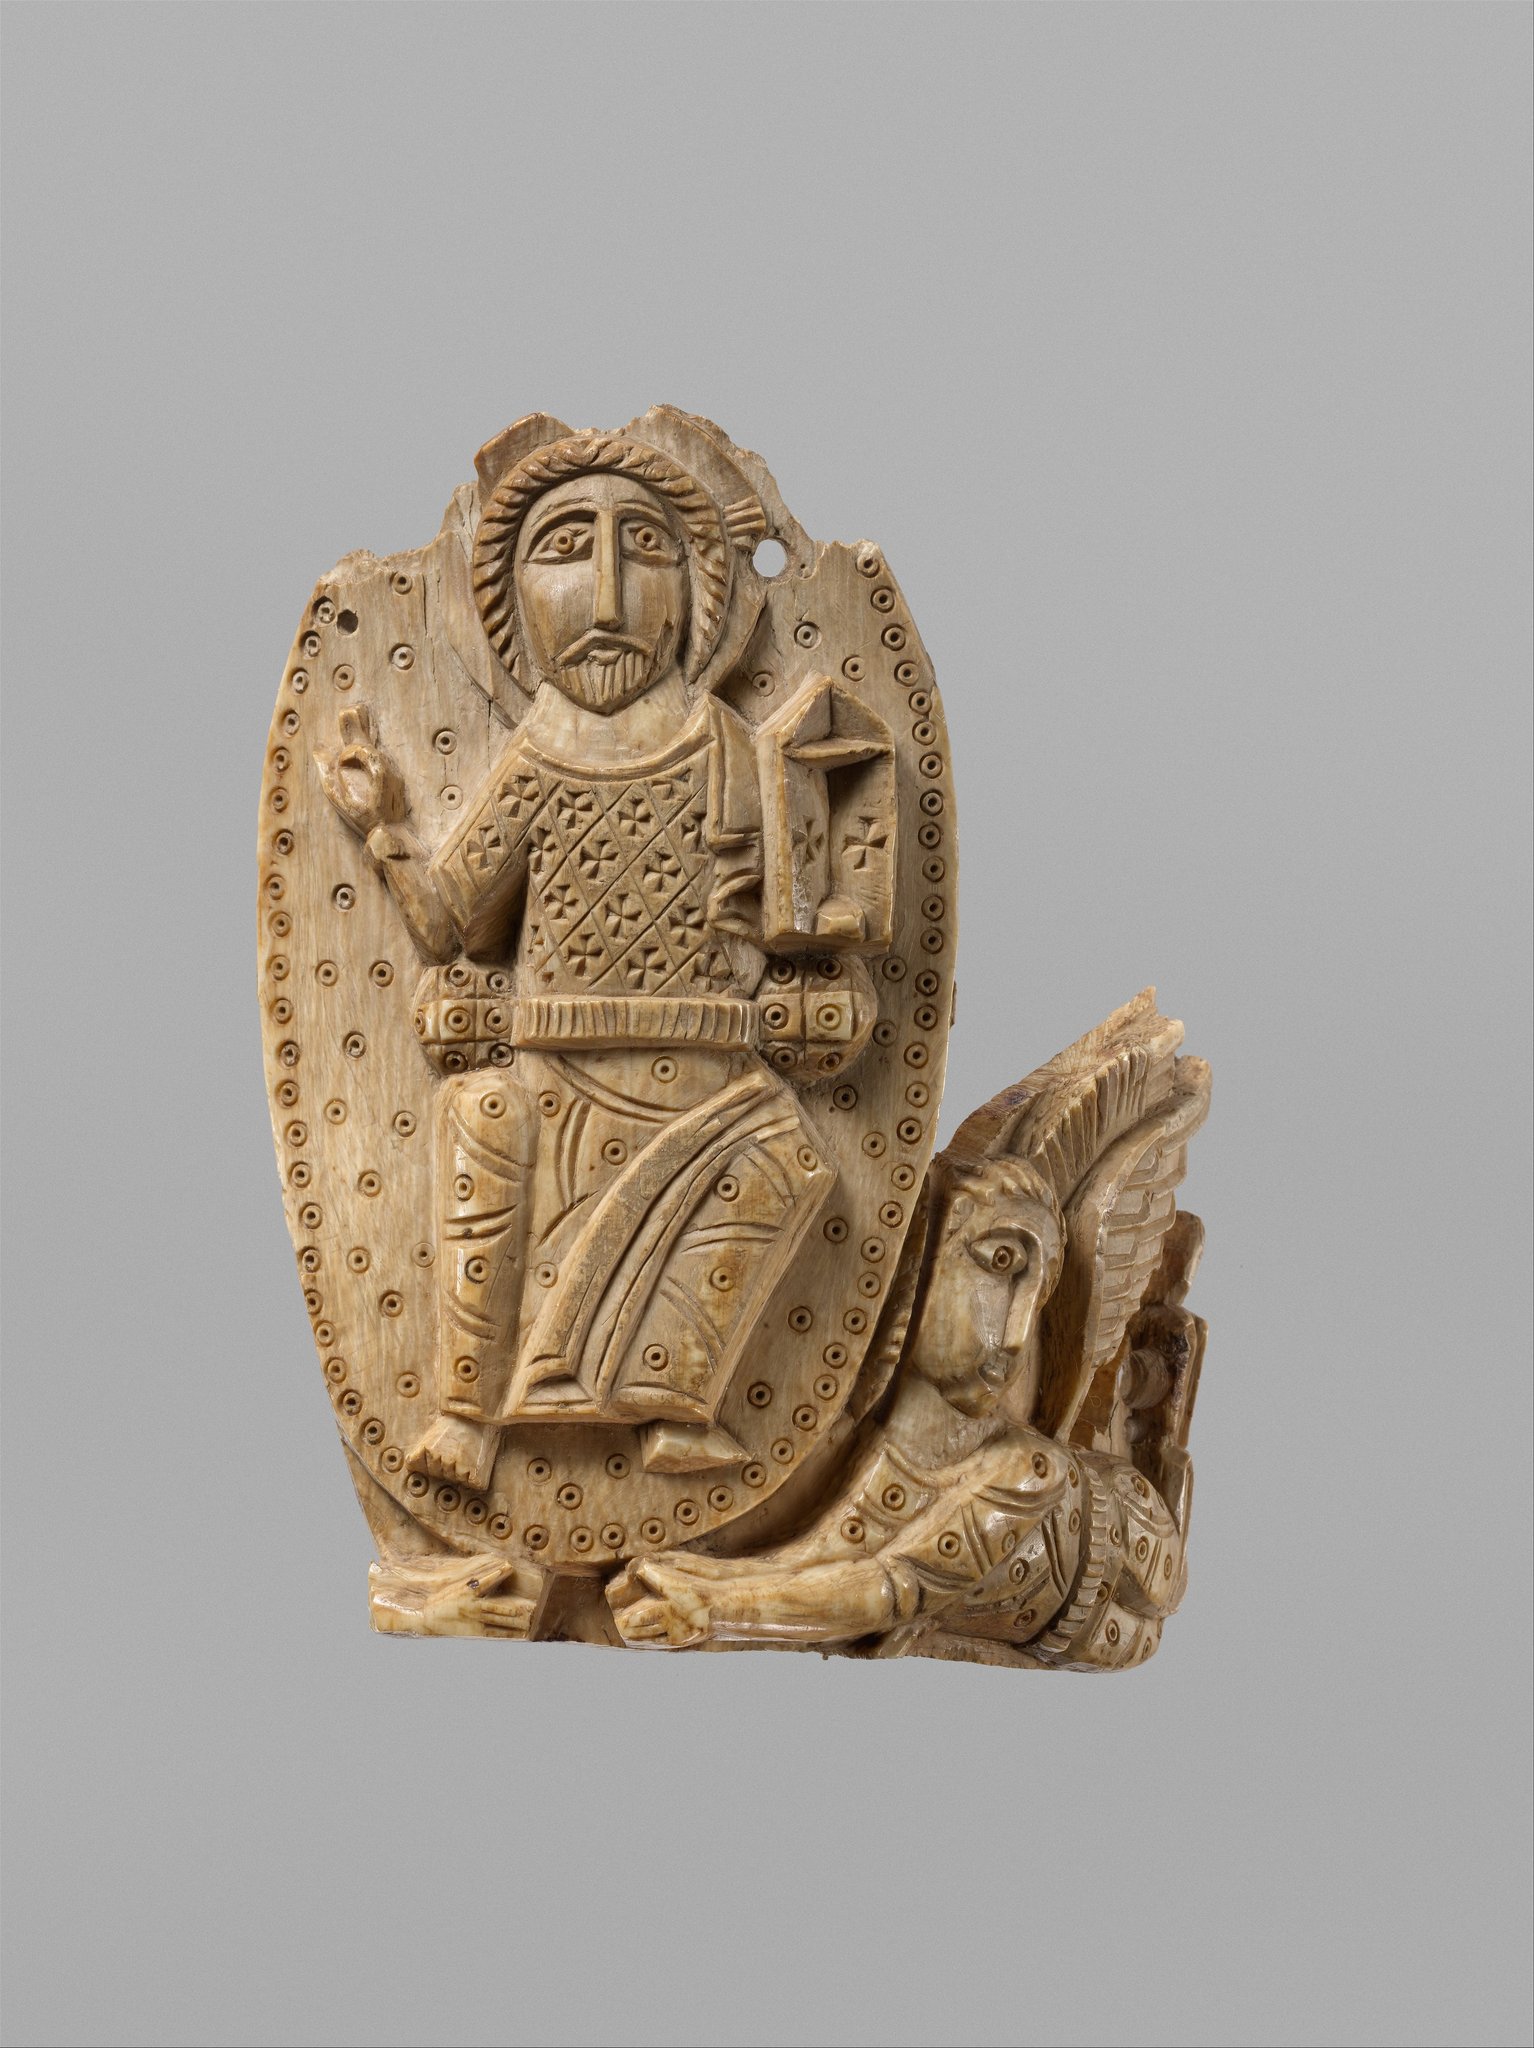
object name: tusk fragment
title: Tusk Fragment with Christ Enthroned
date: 810-1010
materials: ivory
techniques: carving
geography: egypt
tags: angels,christ